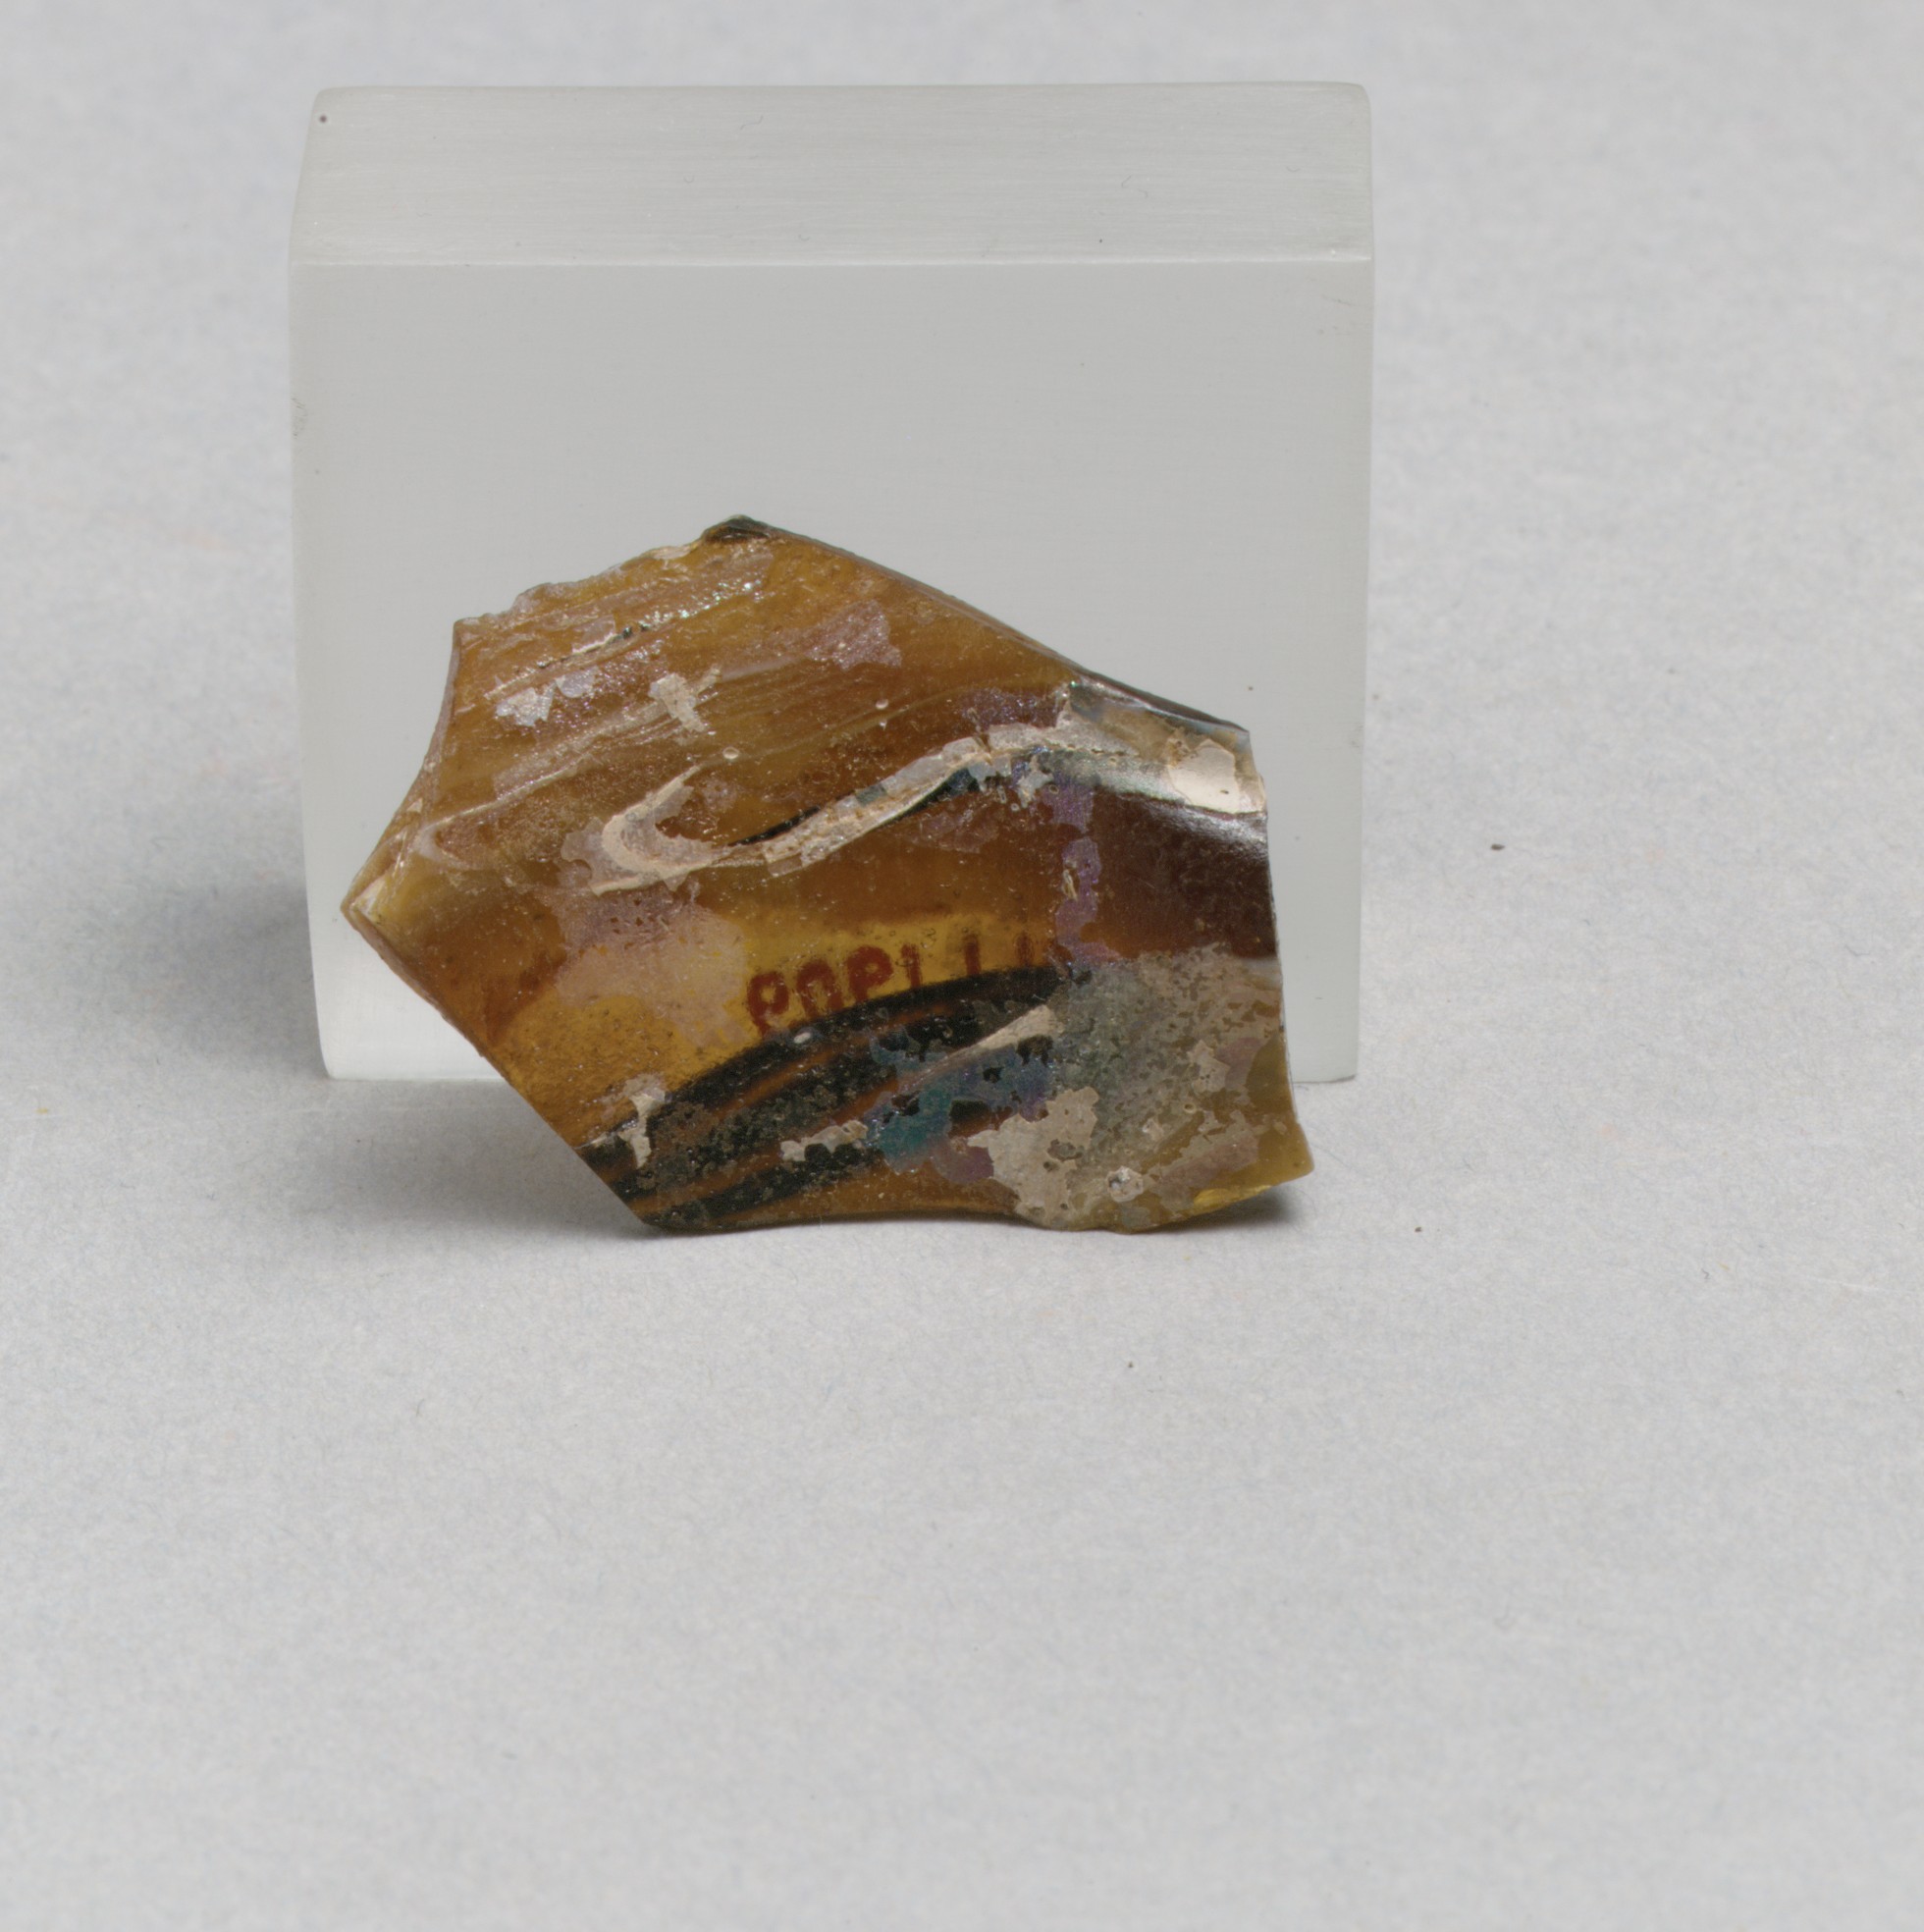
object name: fragment, mosaic bowl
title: Glass mosaic ribbed bowl fragment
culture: roman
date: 34 BCE-33 CE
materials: glass